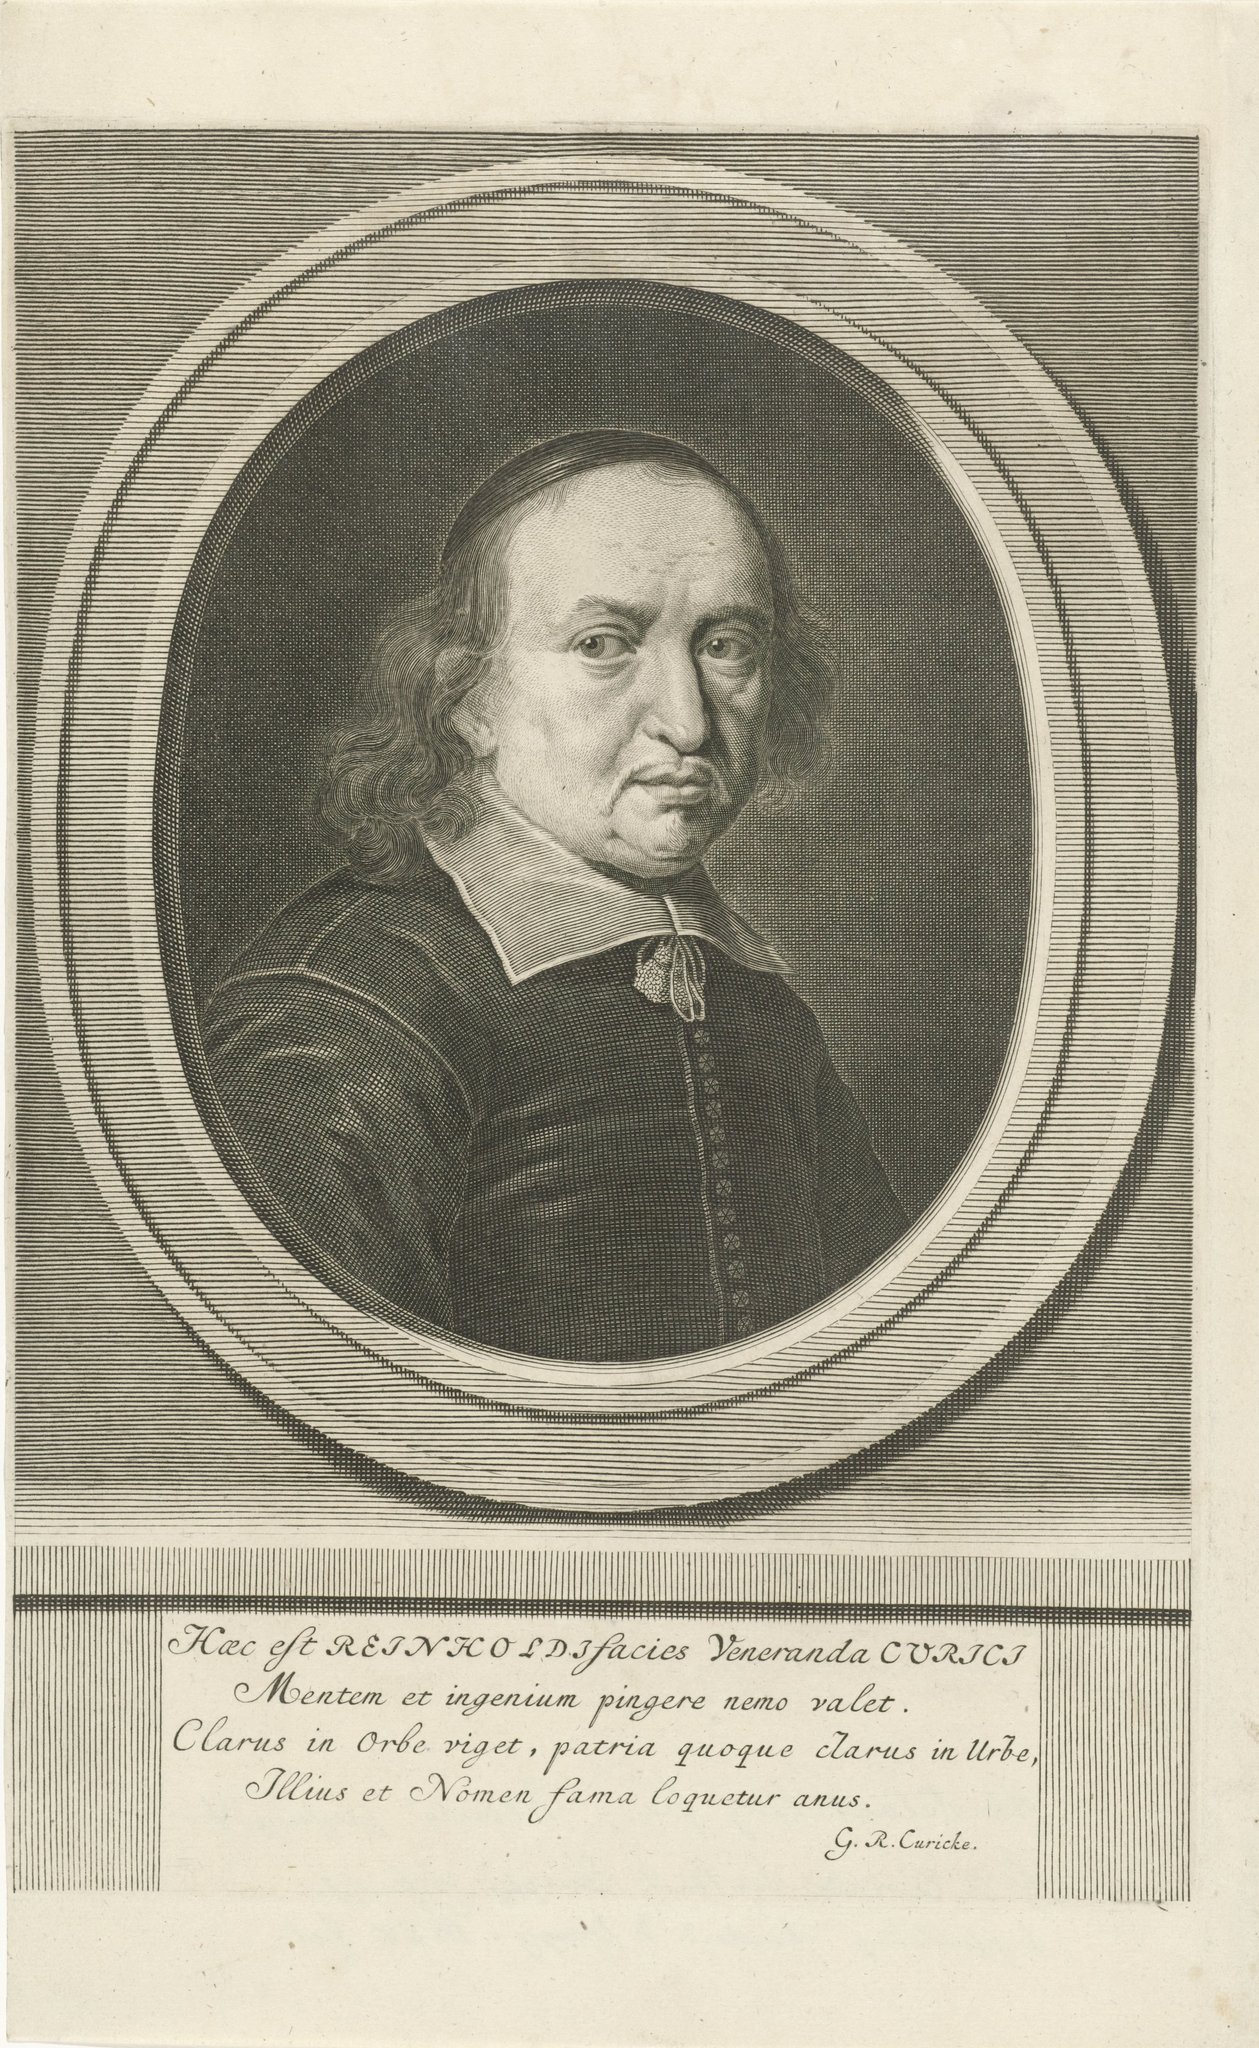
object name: print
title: Portret van Reinhold Curike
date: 1685-1721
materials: paper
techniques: engraving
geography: netherlands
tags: reinhold curike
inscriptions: collector's mark: Lugt 2228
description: Portret van Reinhold Curike, secretaris te Danzig. Onder het portret een vierregelige tekst in het Latijn.